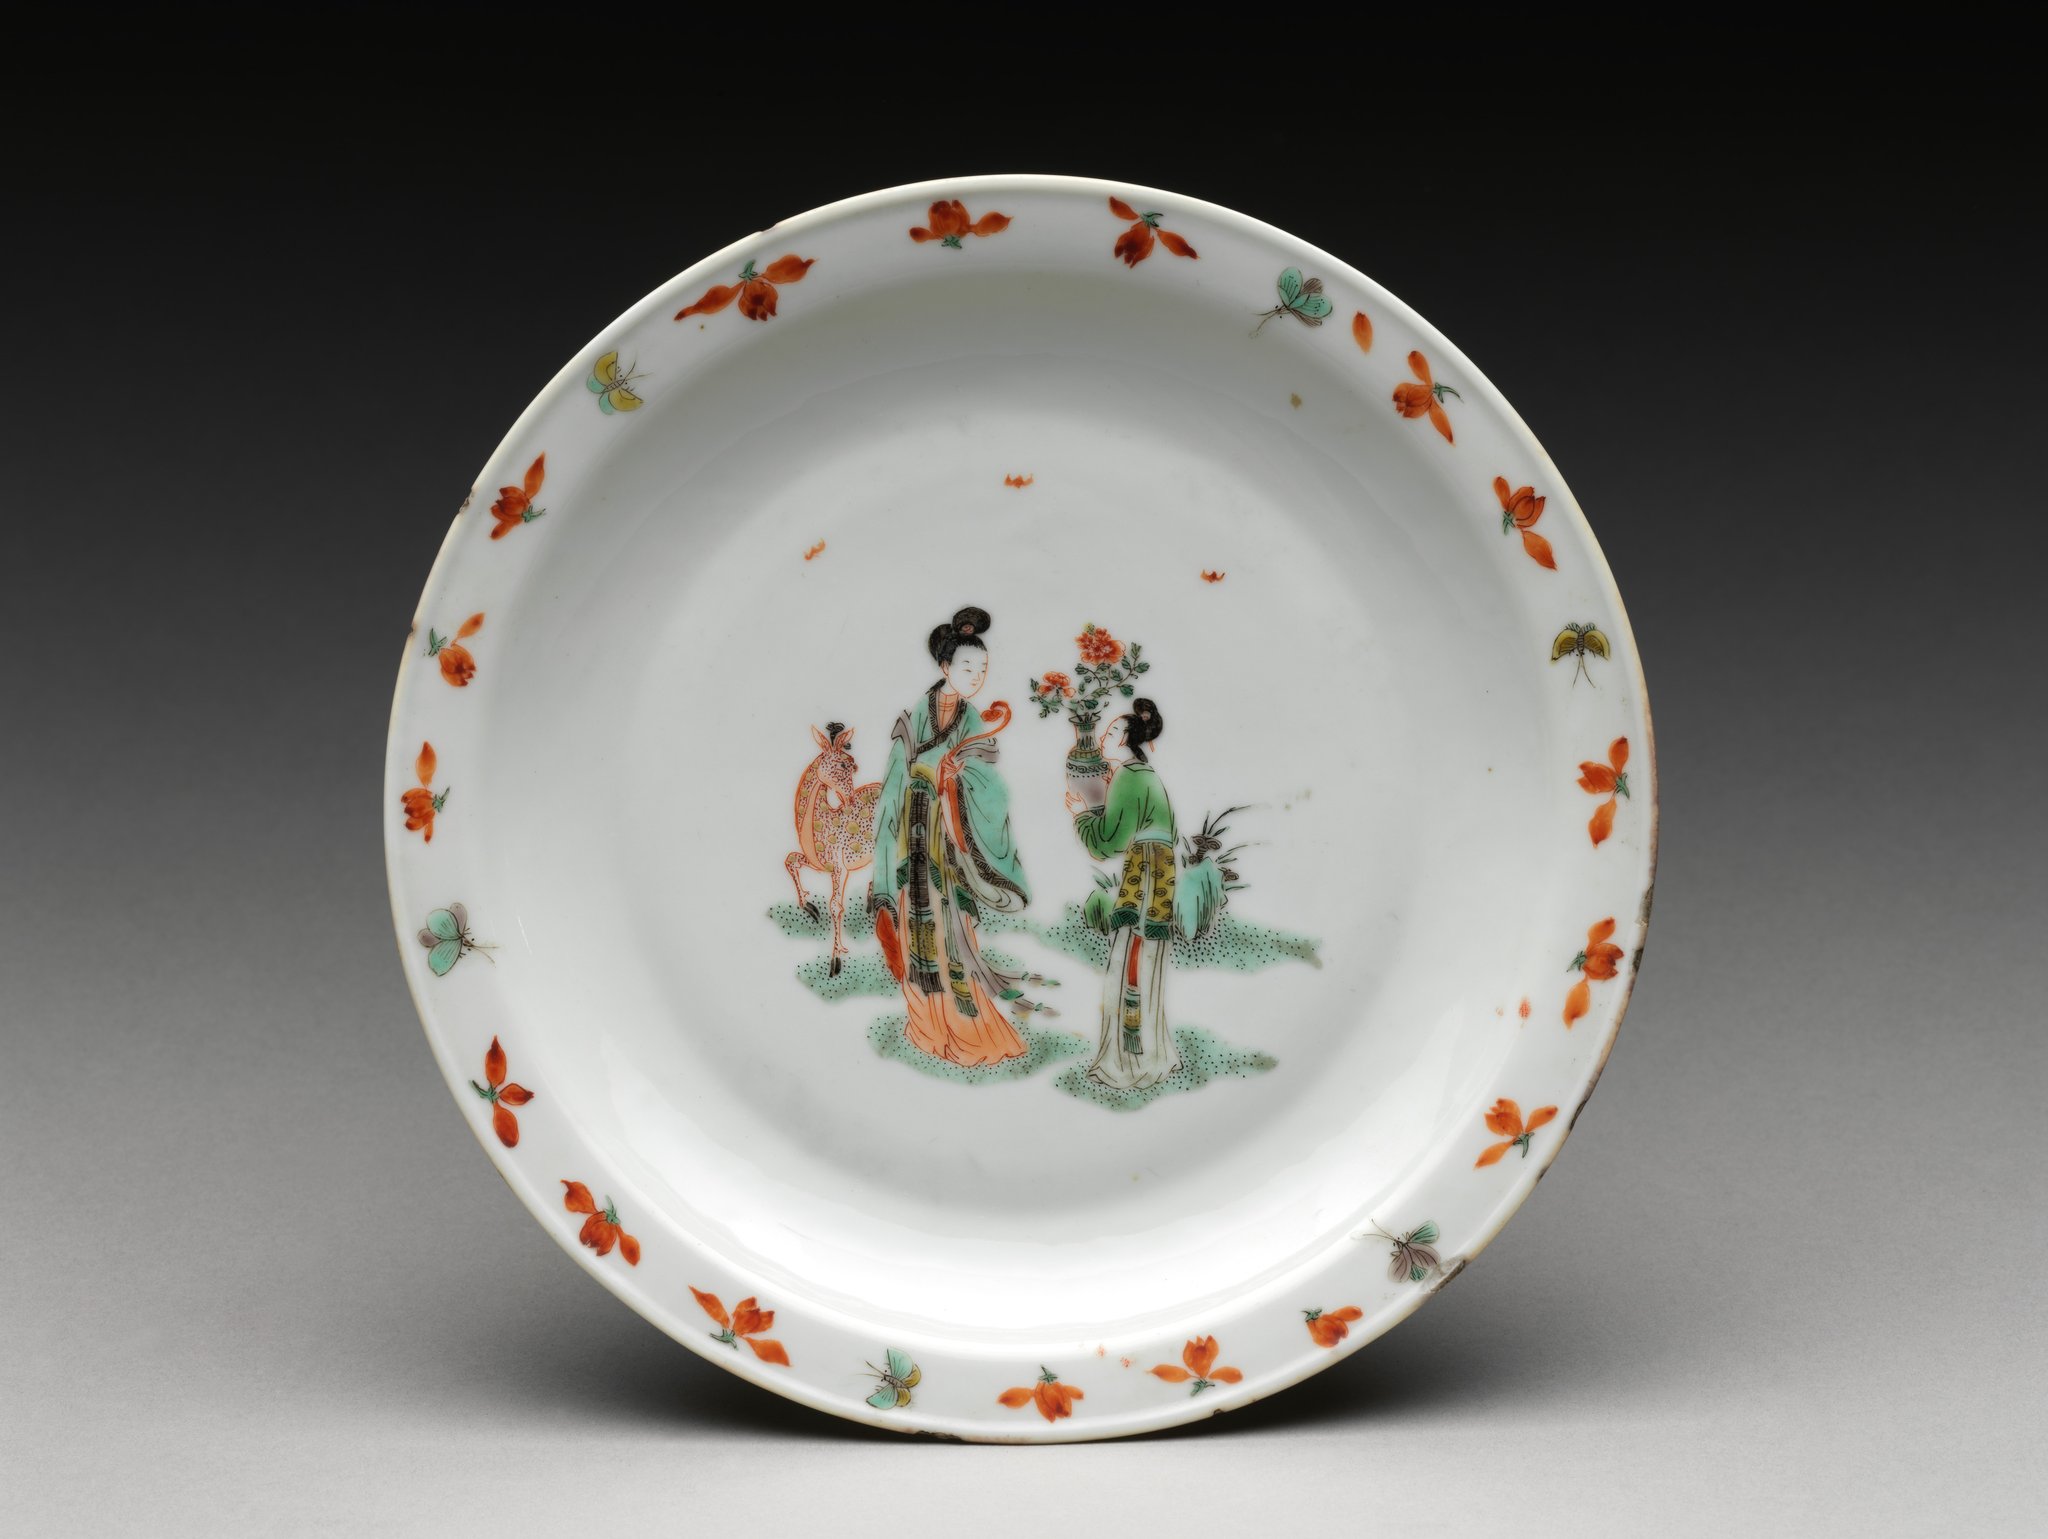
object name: plate one of a pair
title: Plate with fairies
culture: chinese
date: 1662-1722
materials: enamel, porcelain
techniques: overglaze, painting, polychrome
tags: human figures,animals